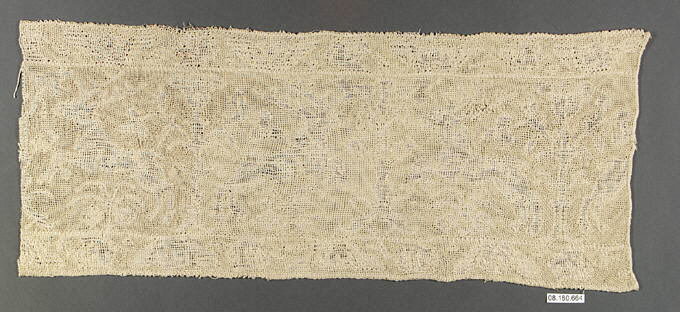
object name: border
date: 1501-1600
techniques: embroidery